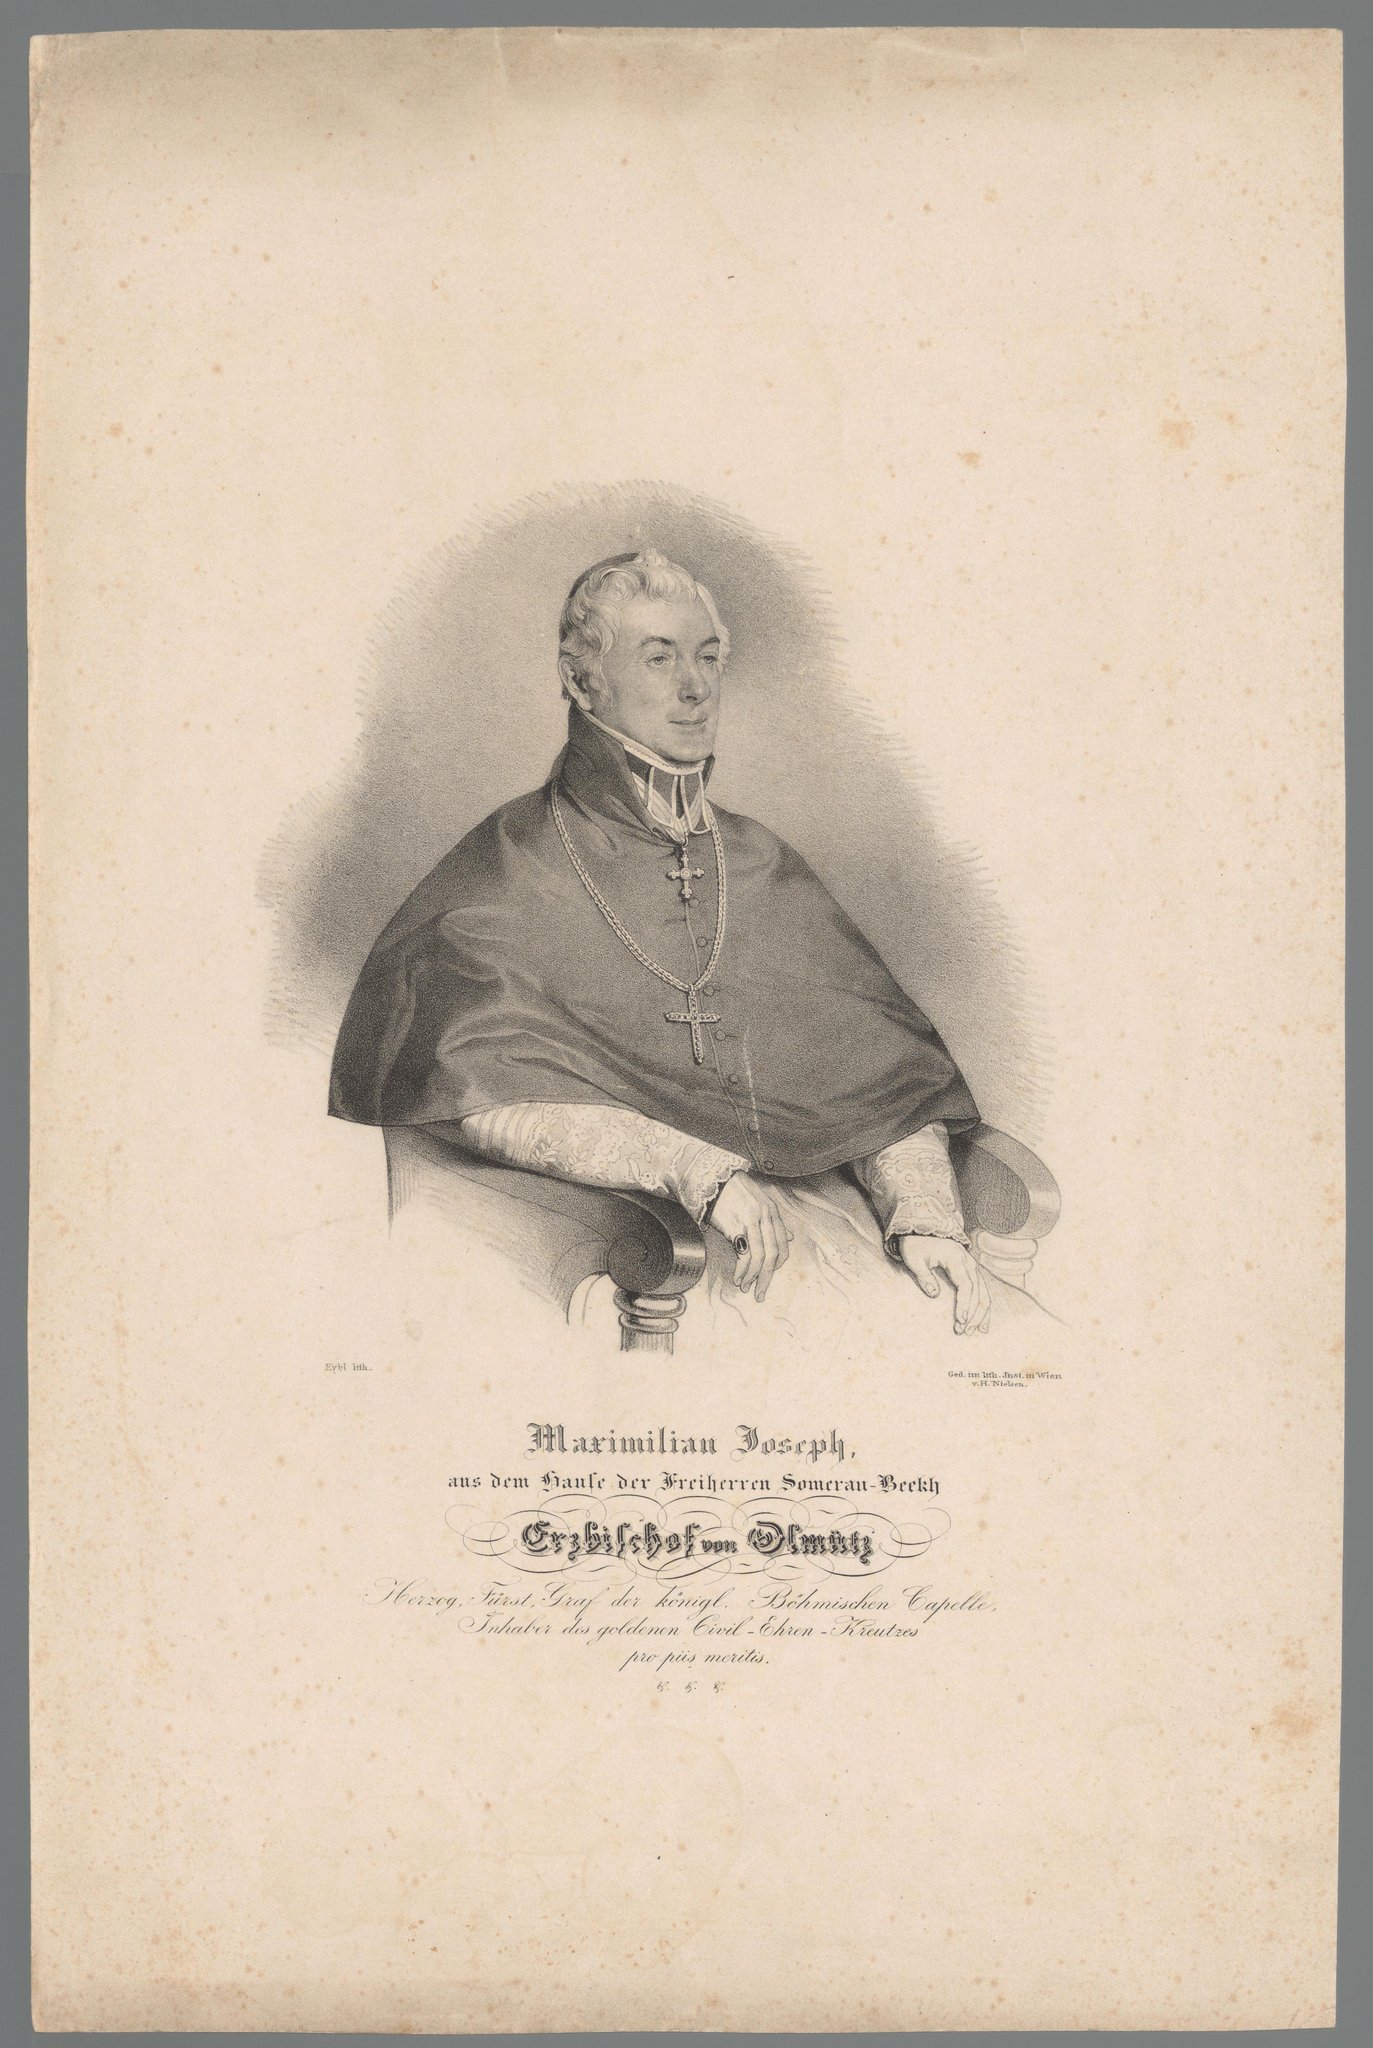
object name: print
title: Portret van Maximilian Joseph Gottfried von Sommerau Beeckh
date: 1816-1880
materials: paper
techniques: lithograph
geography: vienna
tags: vienna, archbishop, bishop, etc. (roman catholic), historical persons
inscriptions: collector's mark: Lugt 2228